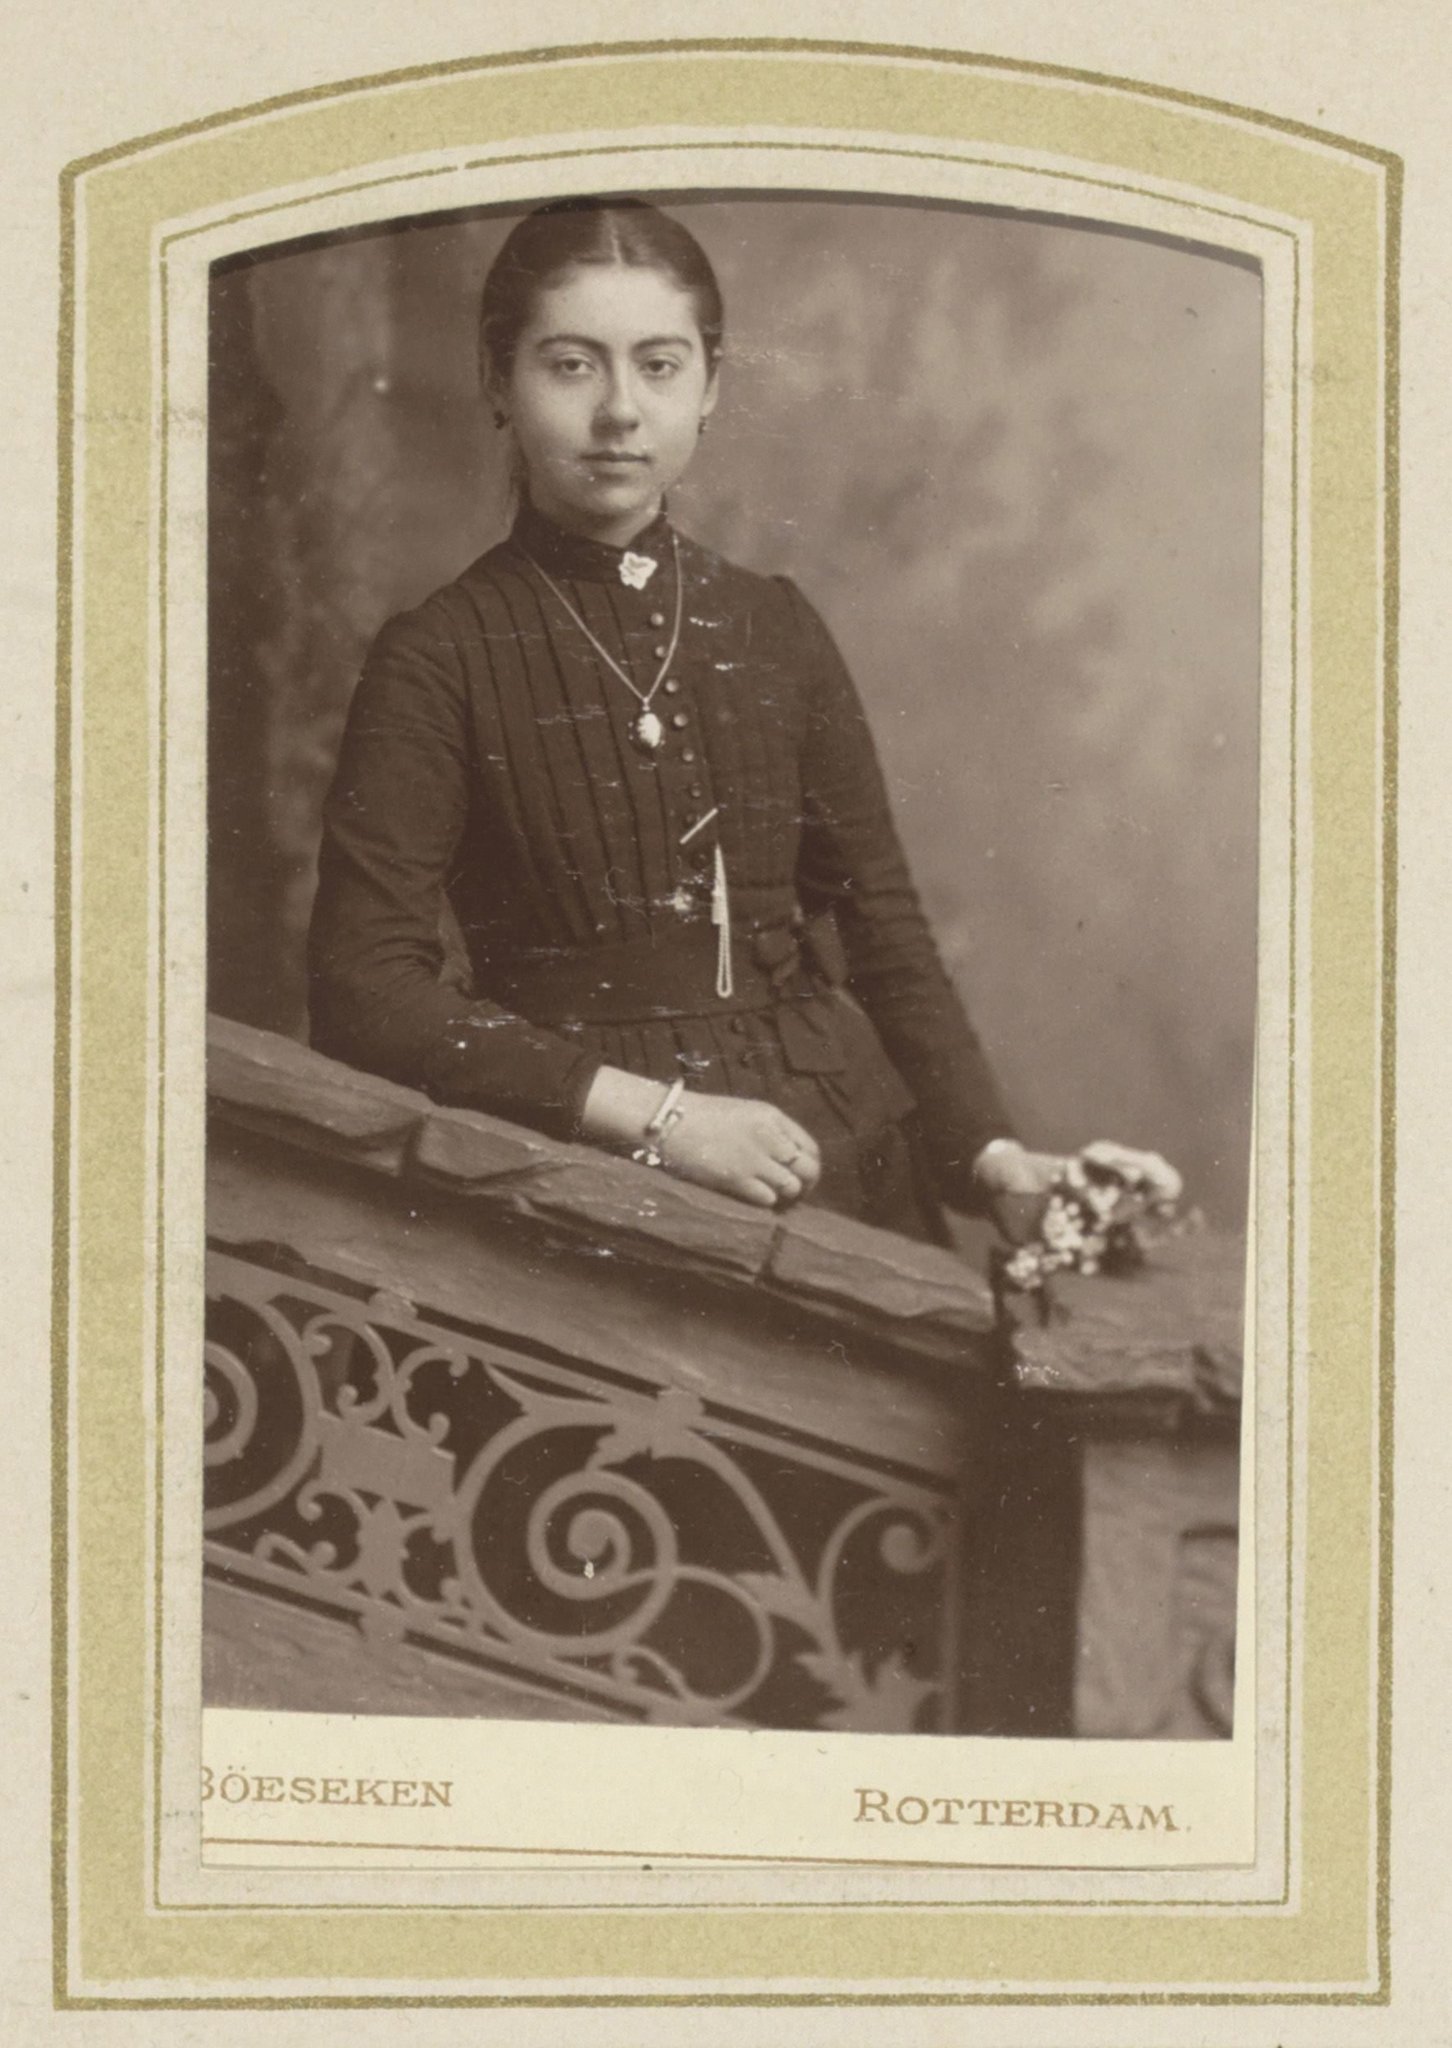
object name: photograph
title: Portret van een jonge vrouw in een jurk met een halsketting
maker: a. böeseken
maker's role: fotograaf, lithograaf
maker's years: 1834-1919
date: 1865-1869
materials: cardboard, paper, photographic support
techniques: daylight paper print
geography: rotterdam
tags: studio requisites ~ photographer, historical persons, clothing for the upper part of the body, brooch, agraffe, clasp, hairdress, necklace, rotterdam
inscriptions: address: ‘Hoogstraat schuins over de Vlasmarkt No. 343’, address: ‘Rotterdam’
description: Onderdeel van Fotoalbum van een Nederlandse familie met 168 cartes-de-visite en kabinetfoto's.